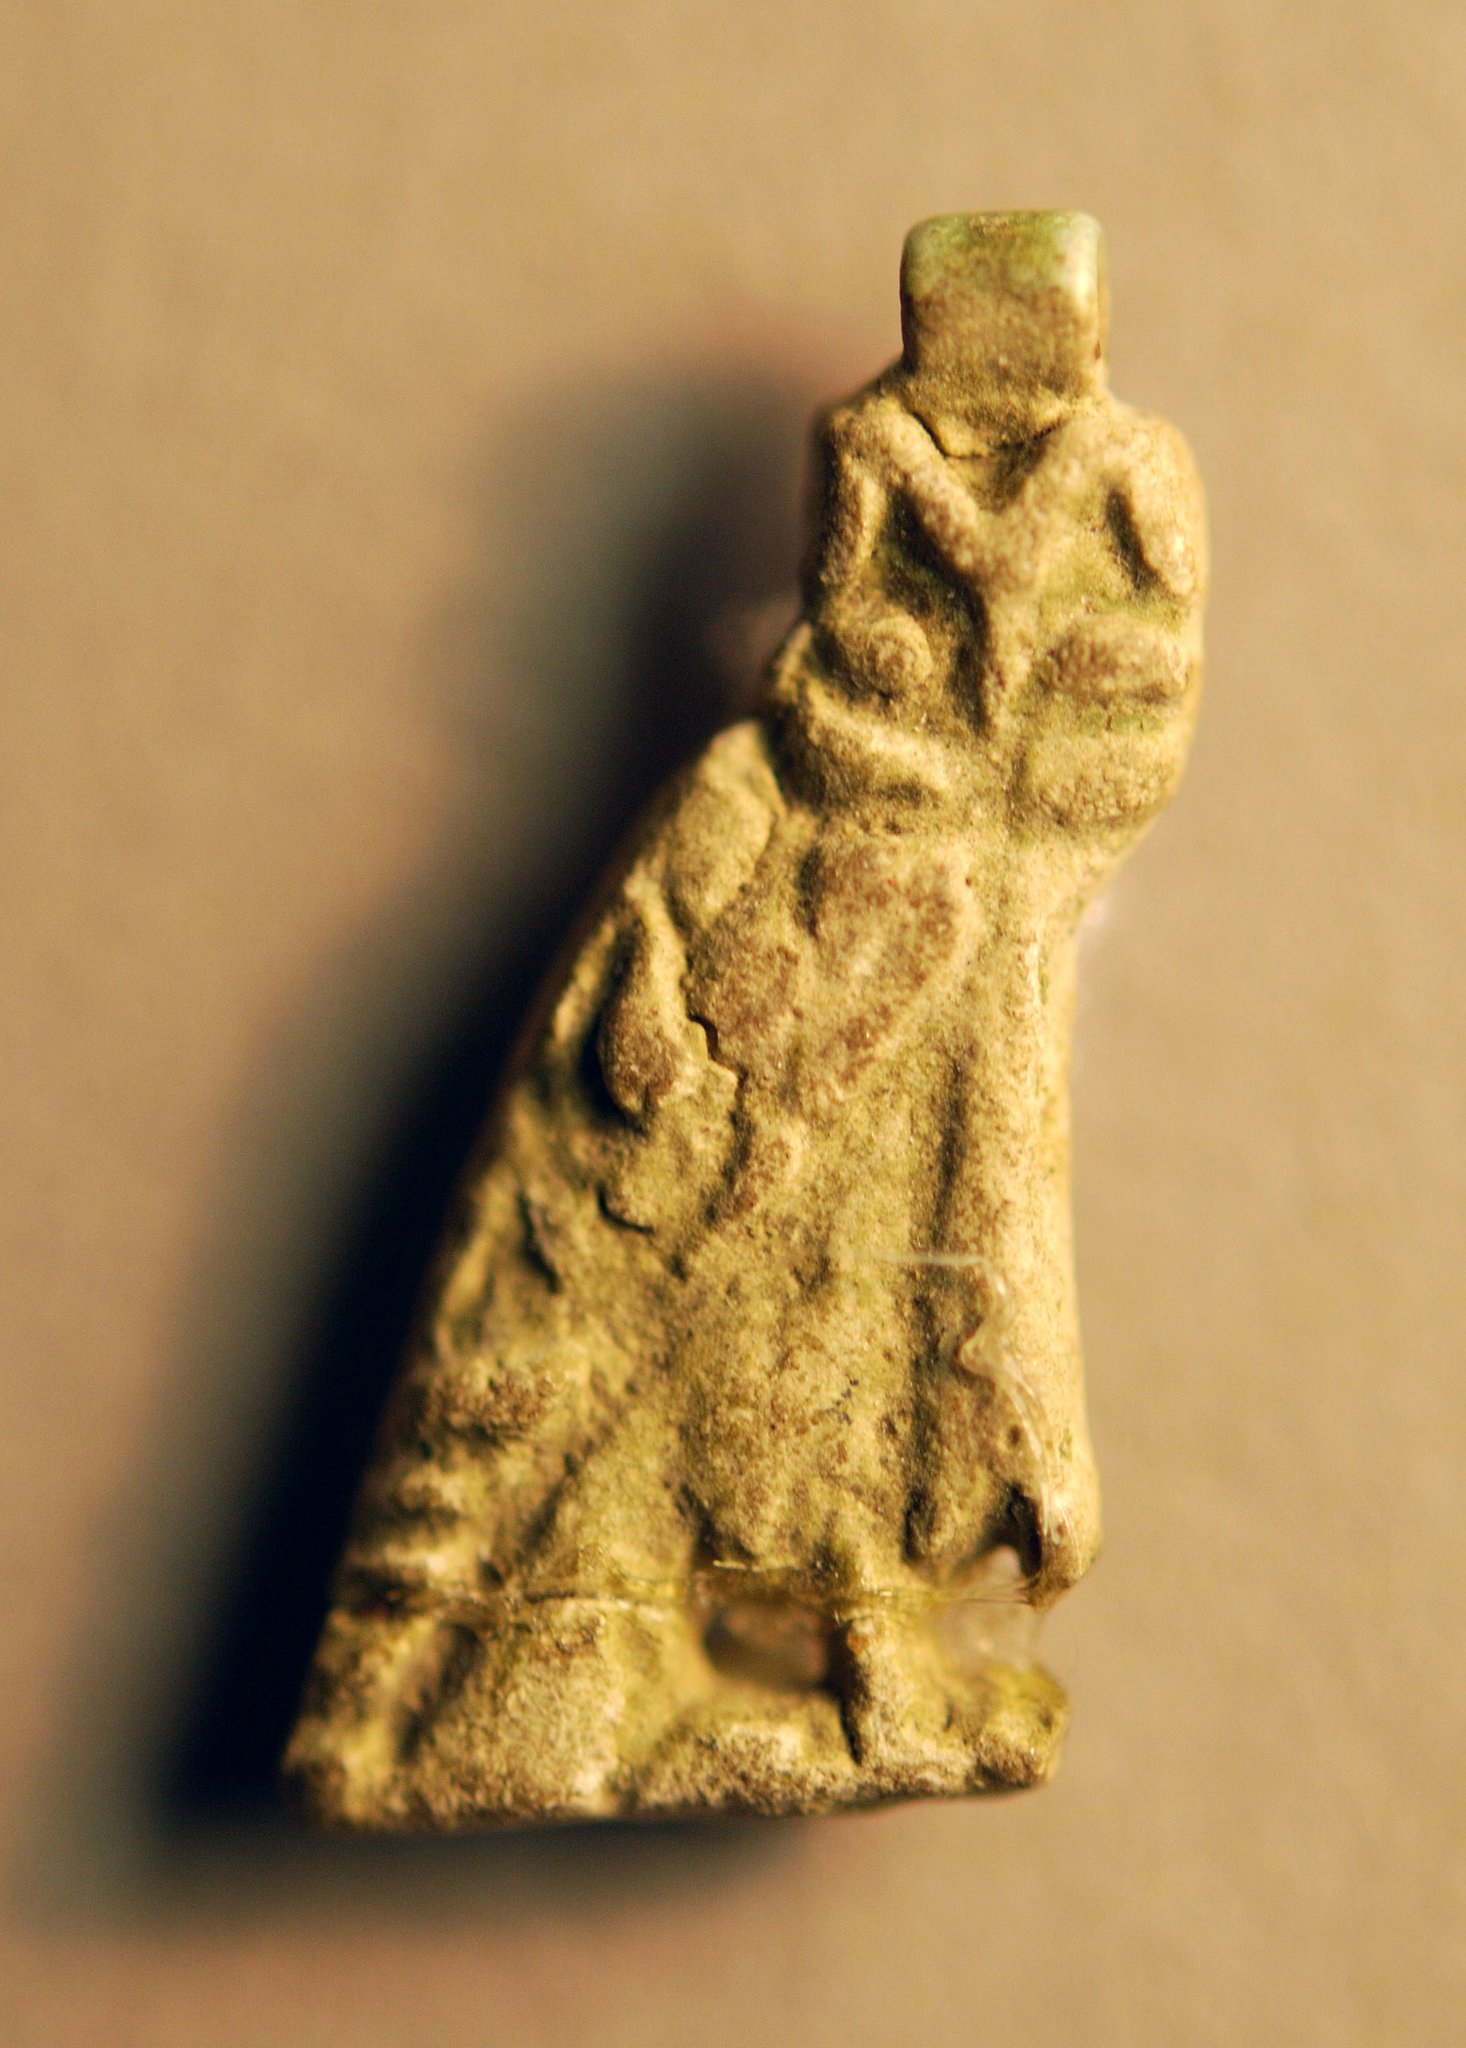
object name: amulet, owl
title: Owl Amulet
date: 1390-1352 BCE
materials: faience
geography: egypt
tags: owls